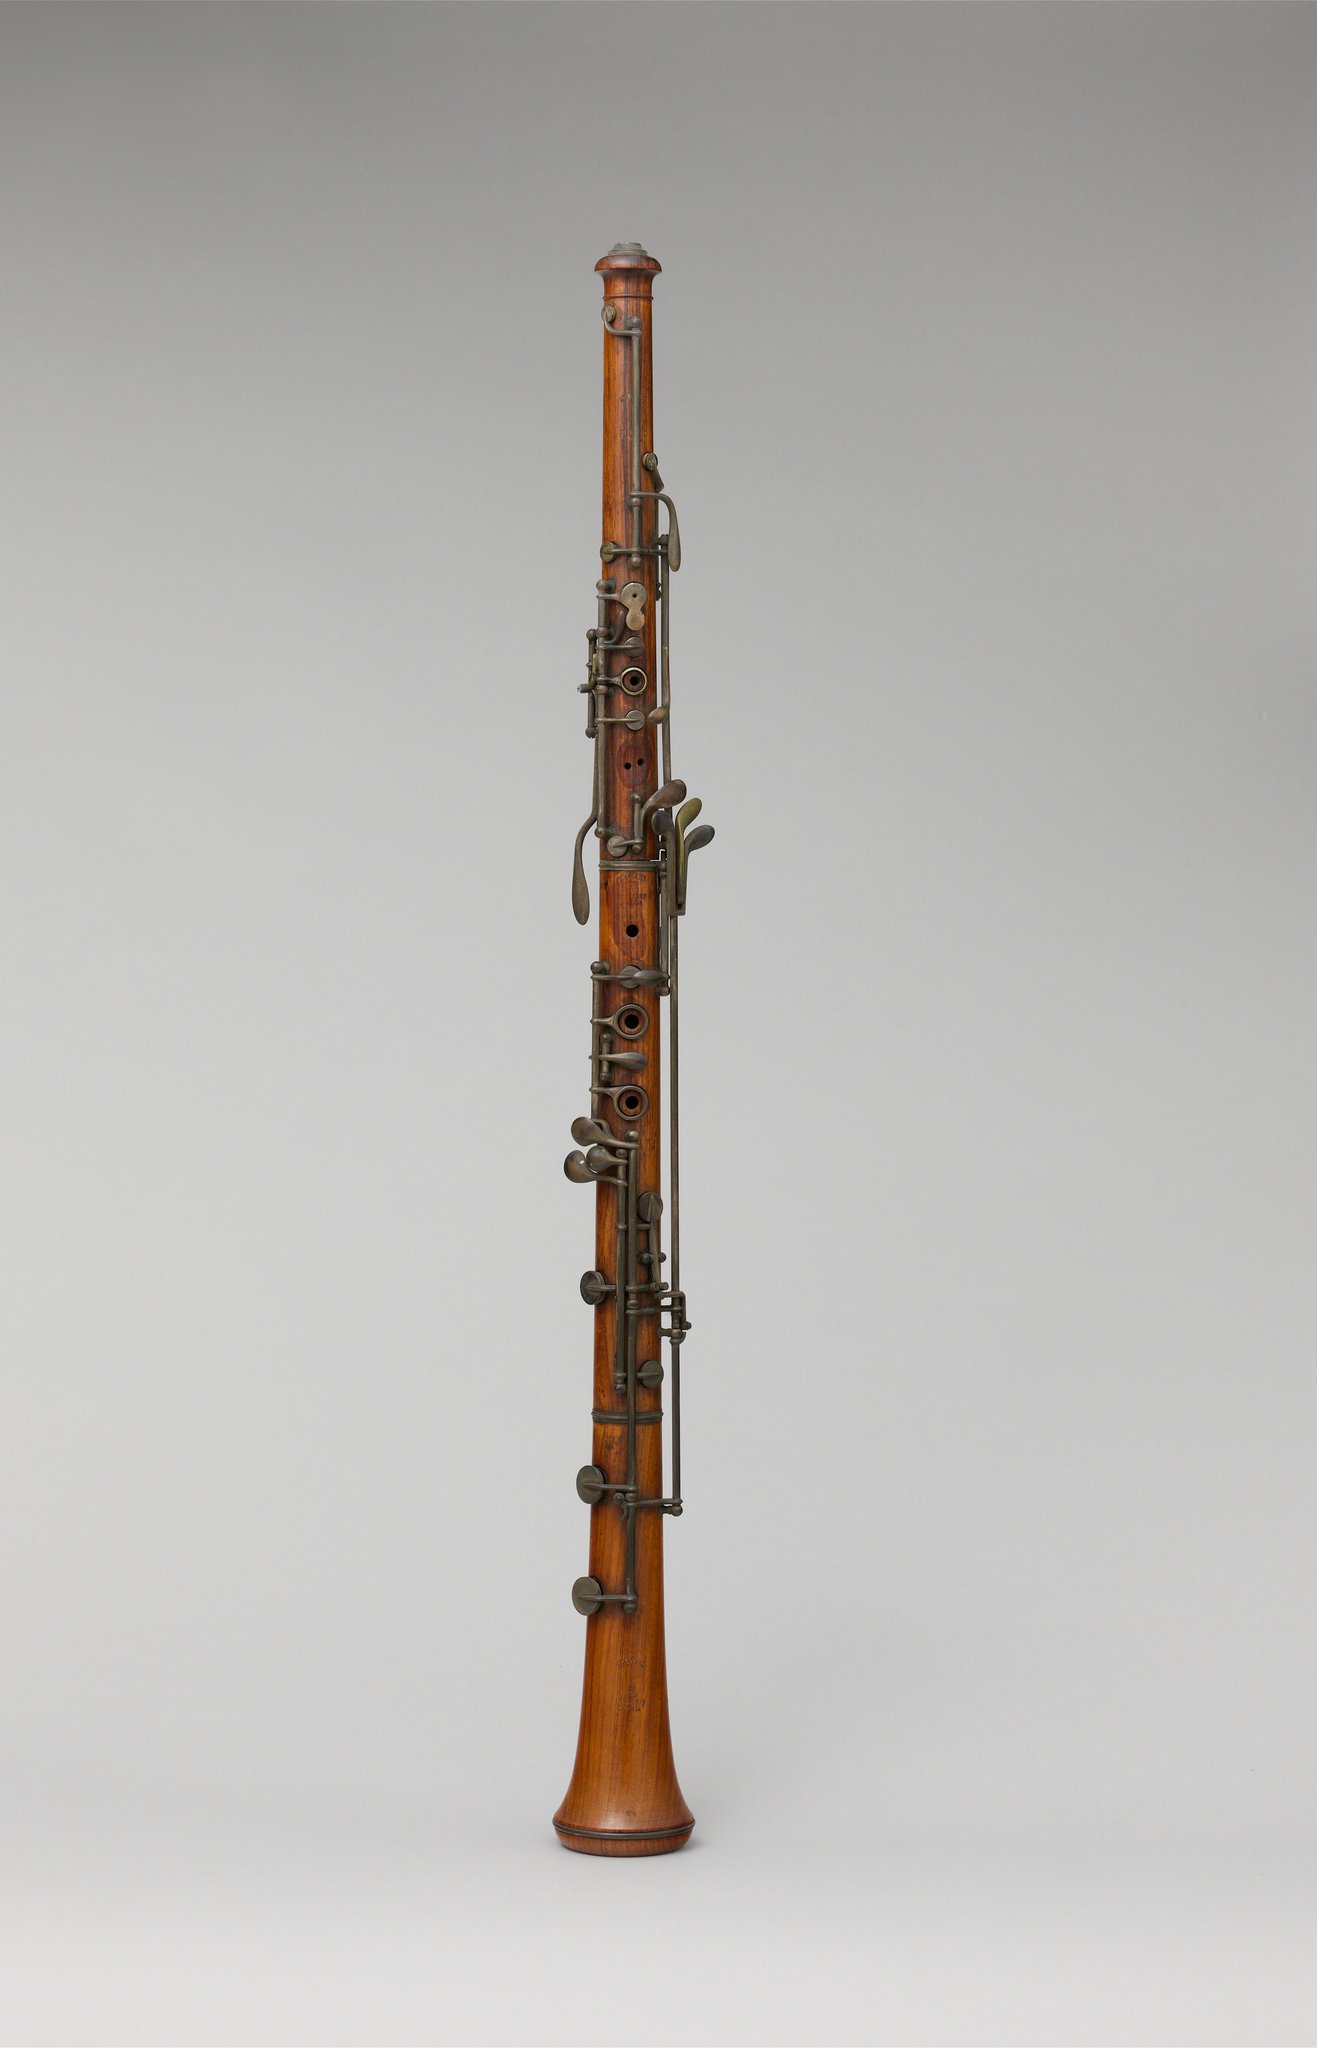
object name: oboe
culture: french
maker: triebert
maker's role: maker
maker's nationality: french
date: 1870-1875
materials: brass, wood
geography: france